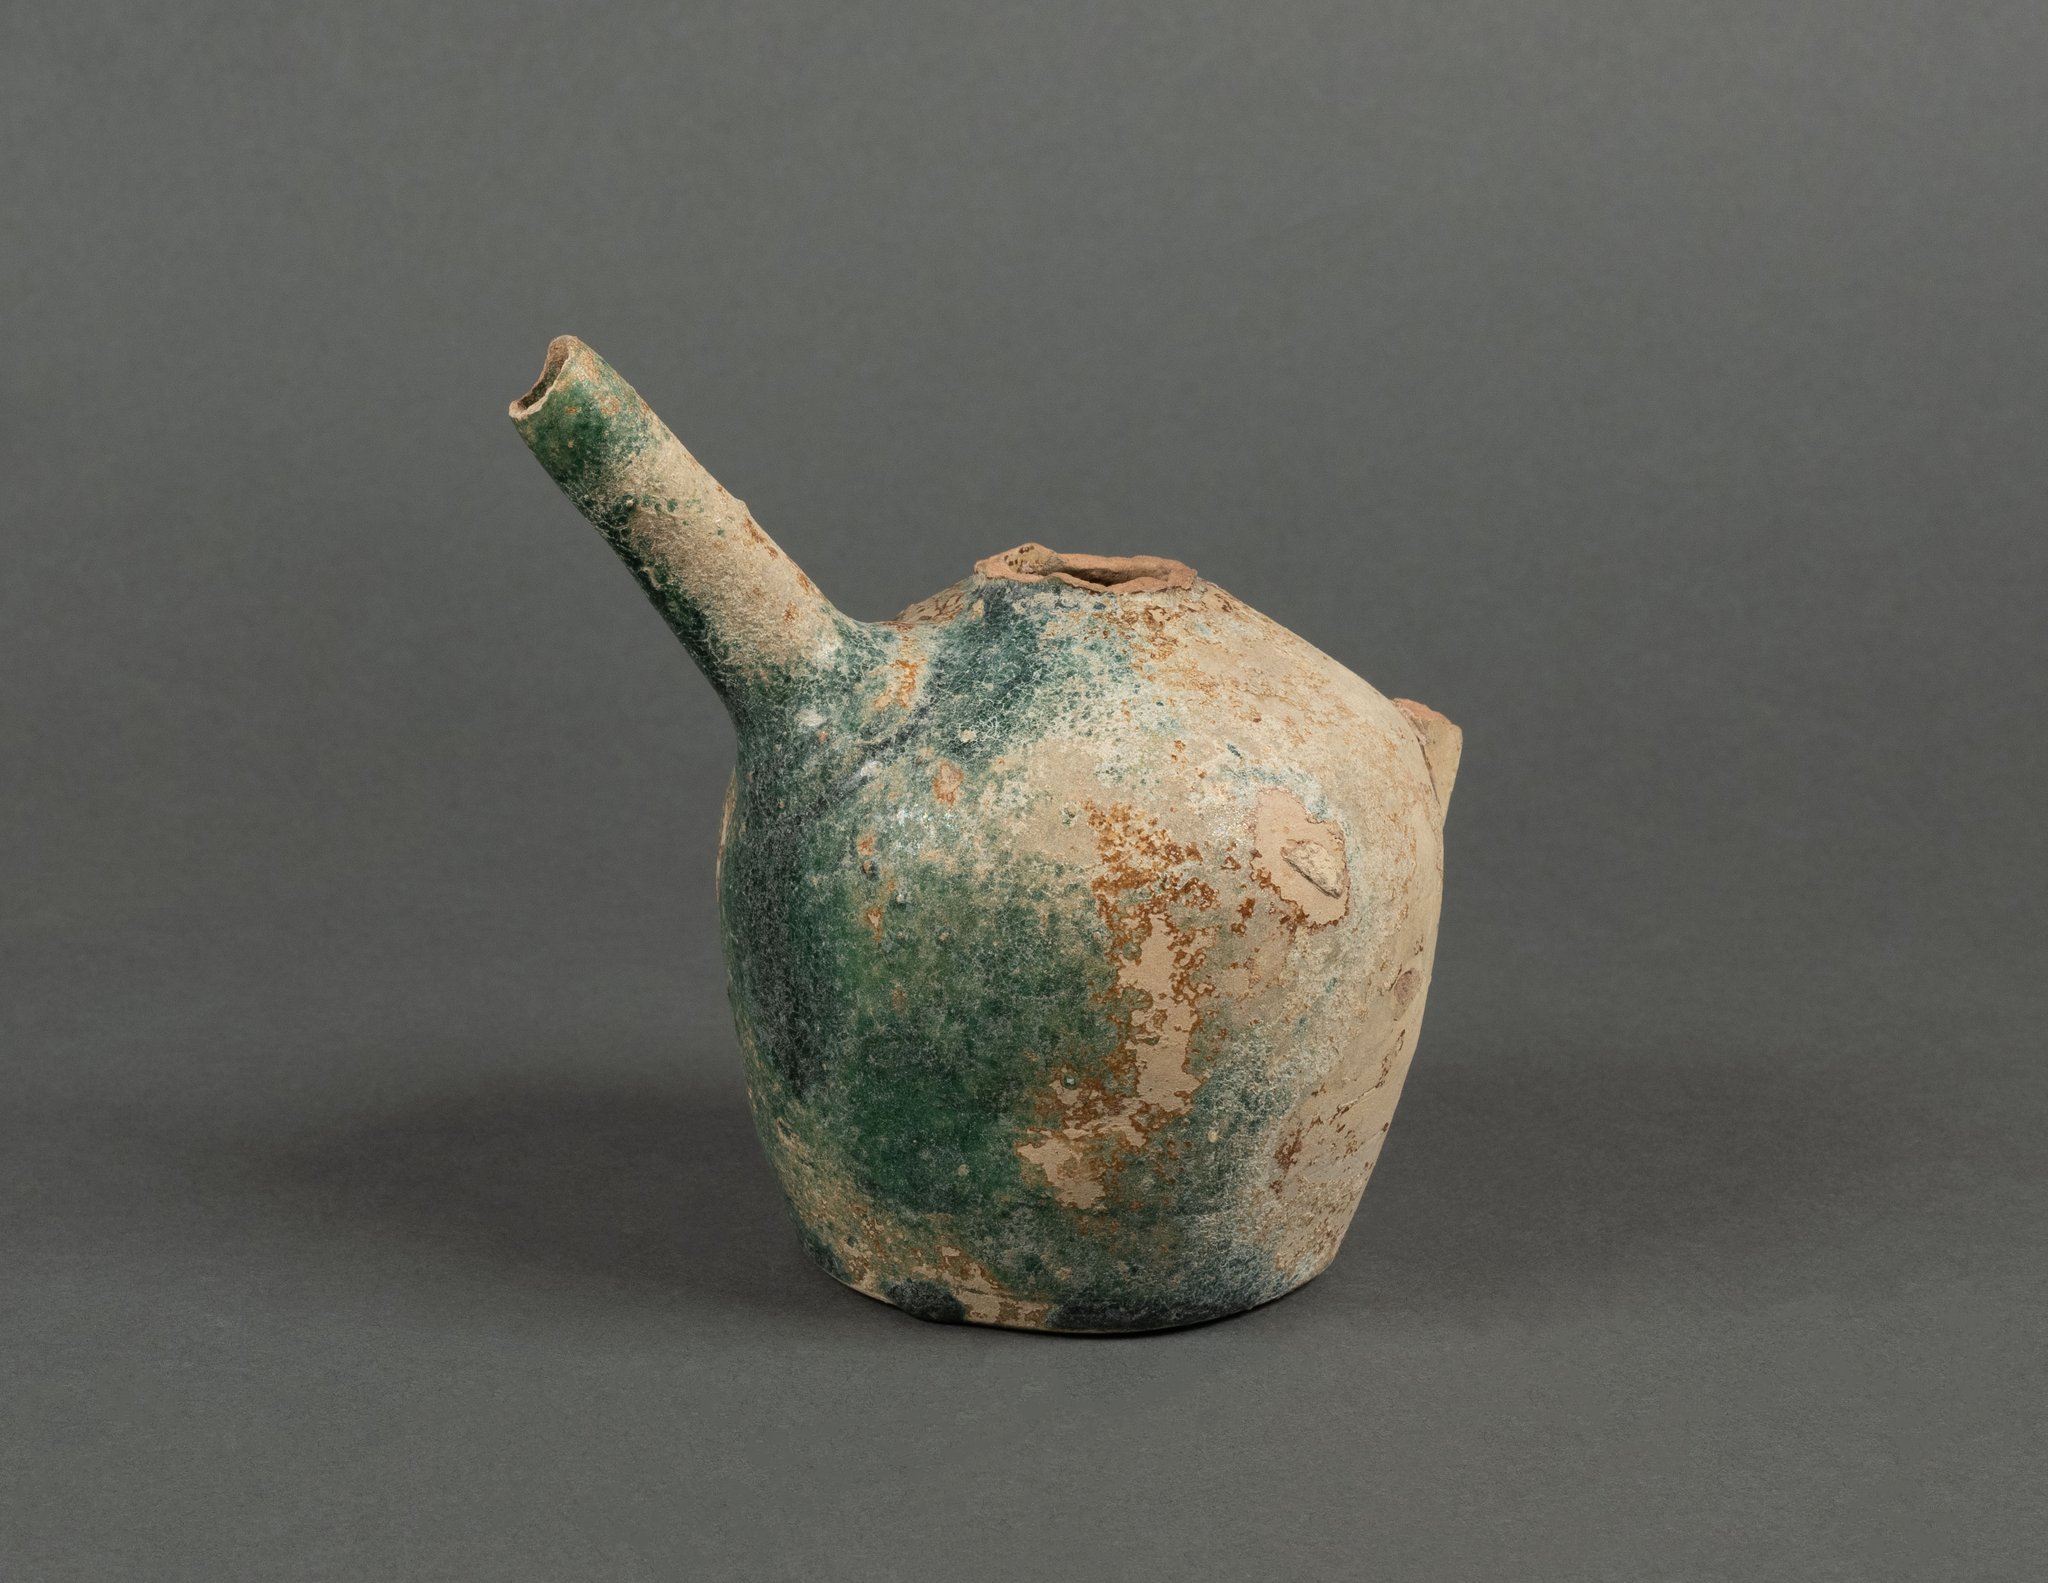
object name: ewer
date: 801-1000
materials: earthenware, glaze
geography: iran